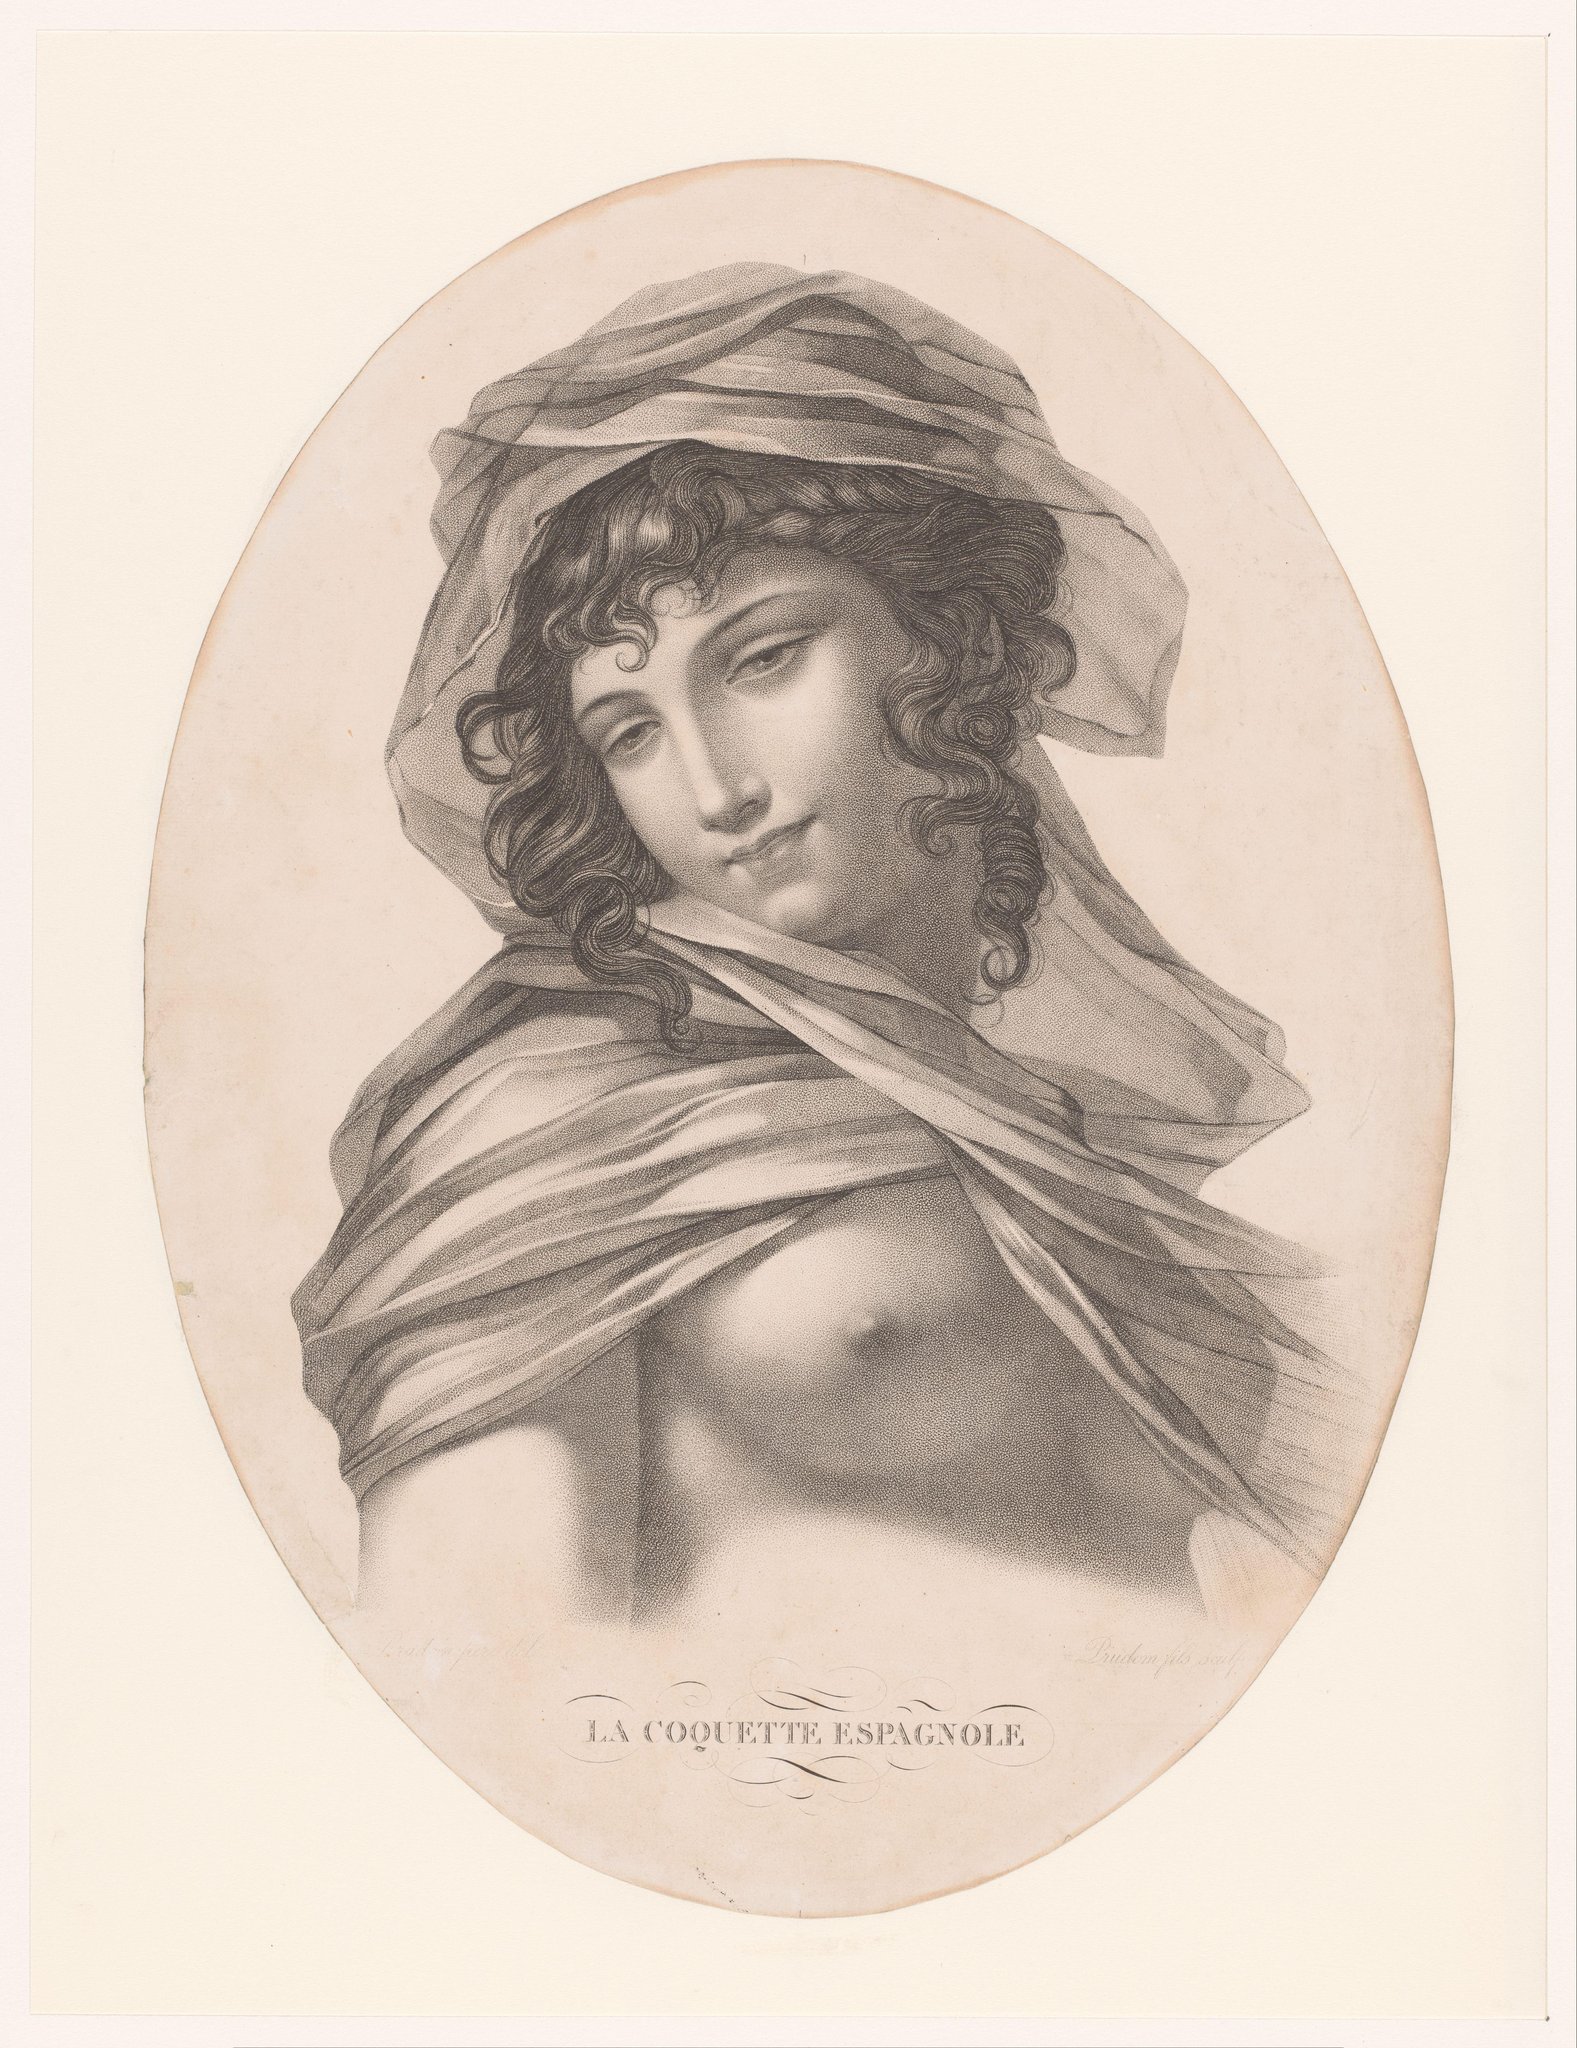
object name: print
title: La Coquette Espagnole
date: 1788-1888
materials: paper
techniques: etching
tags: europeans: spaniards, woman (showing herself) undressed, quasi-nude, veil, chest, bust - aa - female human figure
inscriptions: collector's mark: Lugt 2228